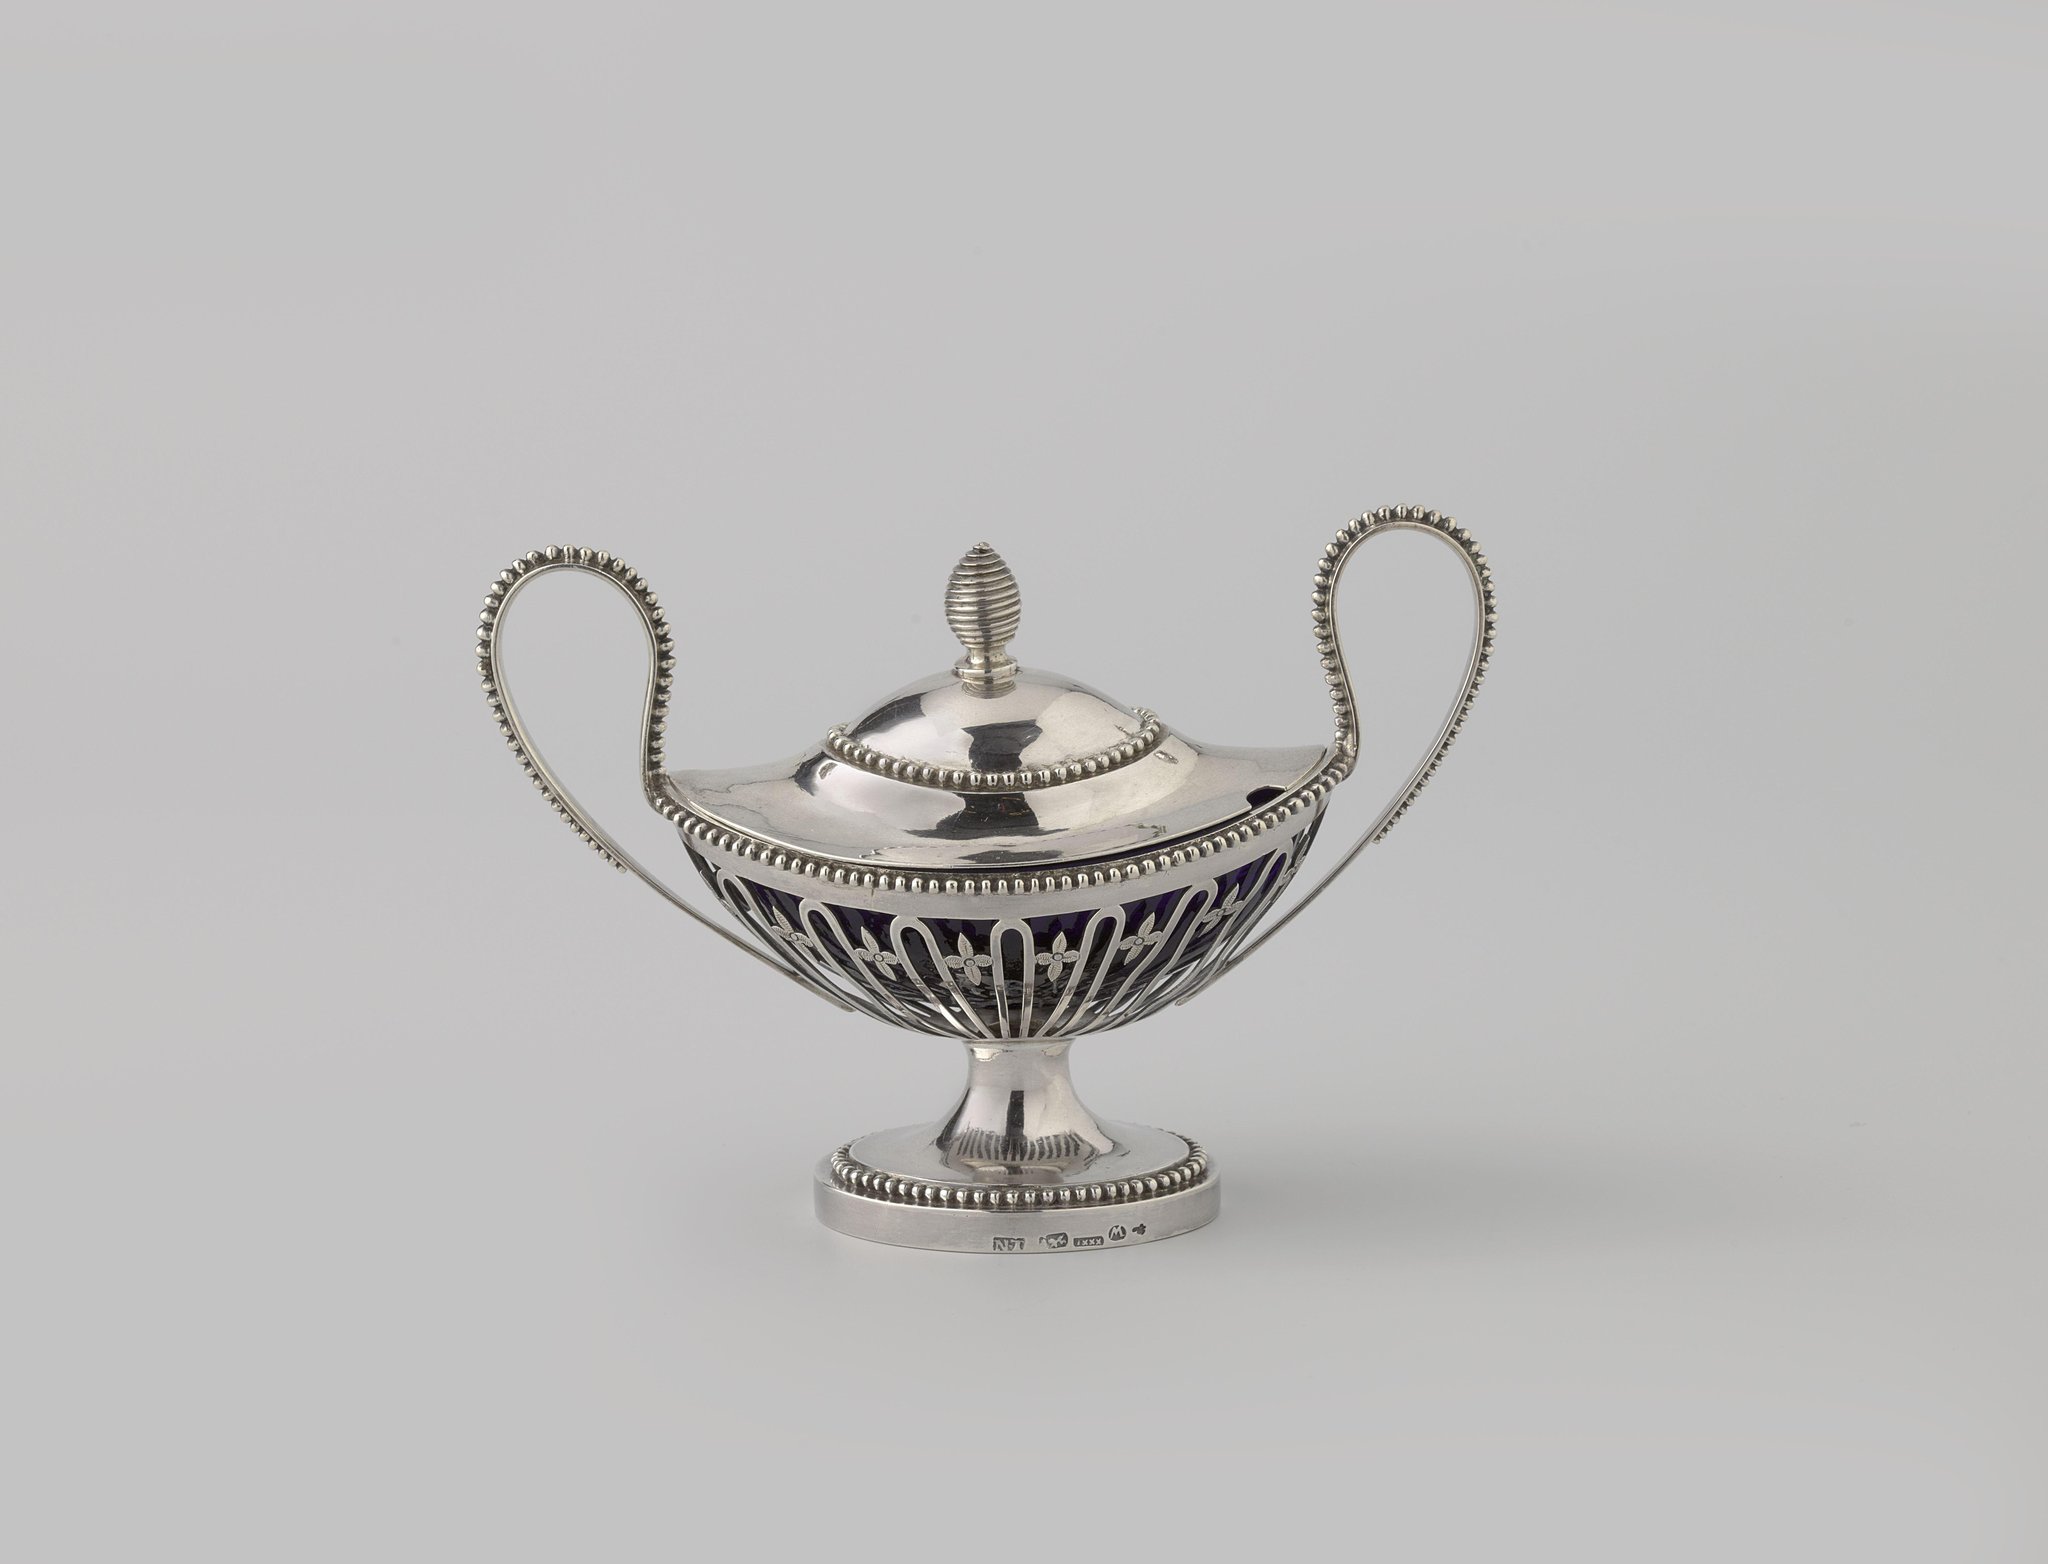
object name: mustard pot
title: Mosterdpot, spitsovaal, met opengewerkte wand met parellijsten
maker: nathanael teuter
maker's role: silversmith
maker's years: 1767-1831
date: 1805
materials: silver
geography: amsterdam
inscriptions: town mark, duty mark, maker's mark, date letter: ‘W’, alloy mark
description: De vier spits ovale, gewelfde vaten (A, B,C en D), die aan de zijkanten iets verhoogde wanden hebben, rusten elk op een ovale, zich naar boven sterk verjongende voet op een rechtwandige basis. Op het met afwisselend knerren en rozetten opengewerkte lichaam past een scharnierend, gewelfd deksel dat wordt bekroond door een geribde pijnappelvormige knop. Rond de voet, rond de bovenrand van het lichaam, over de hoog oplopende, gebogen oren en rond het deksel lopen parellijsten.